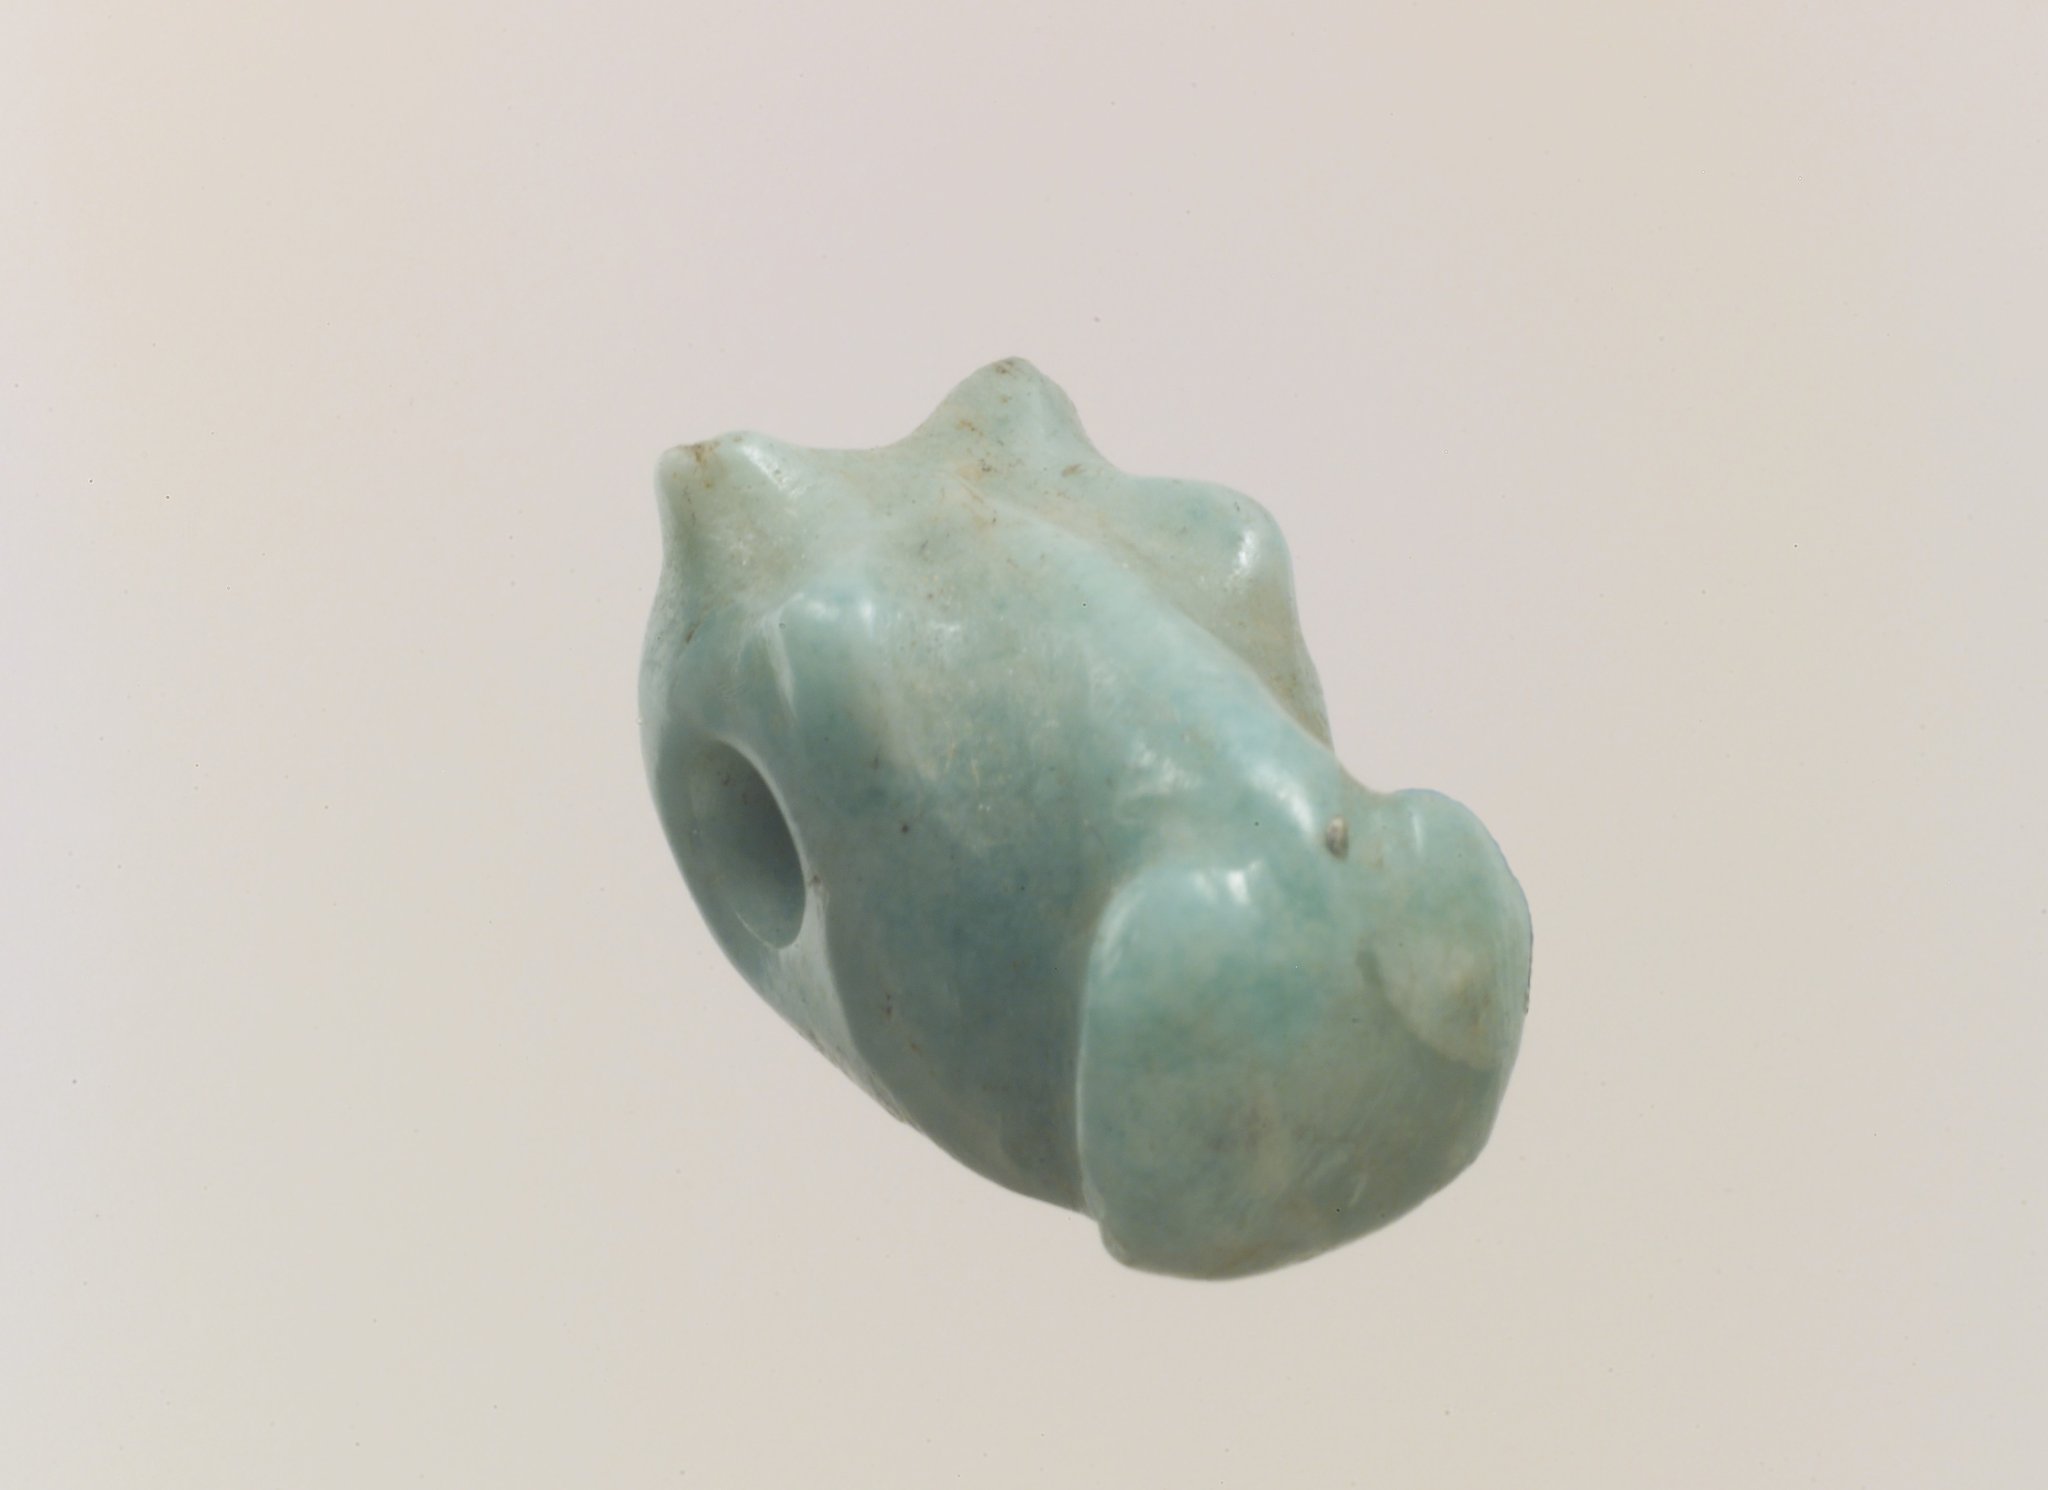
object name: amulet, hippopotamus head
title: Hippopotamus-head amulet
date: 1981-1802 BCE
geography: egypt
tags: hippos